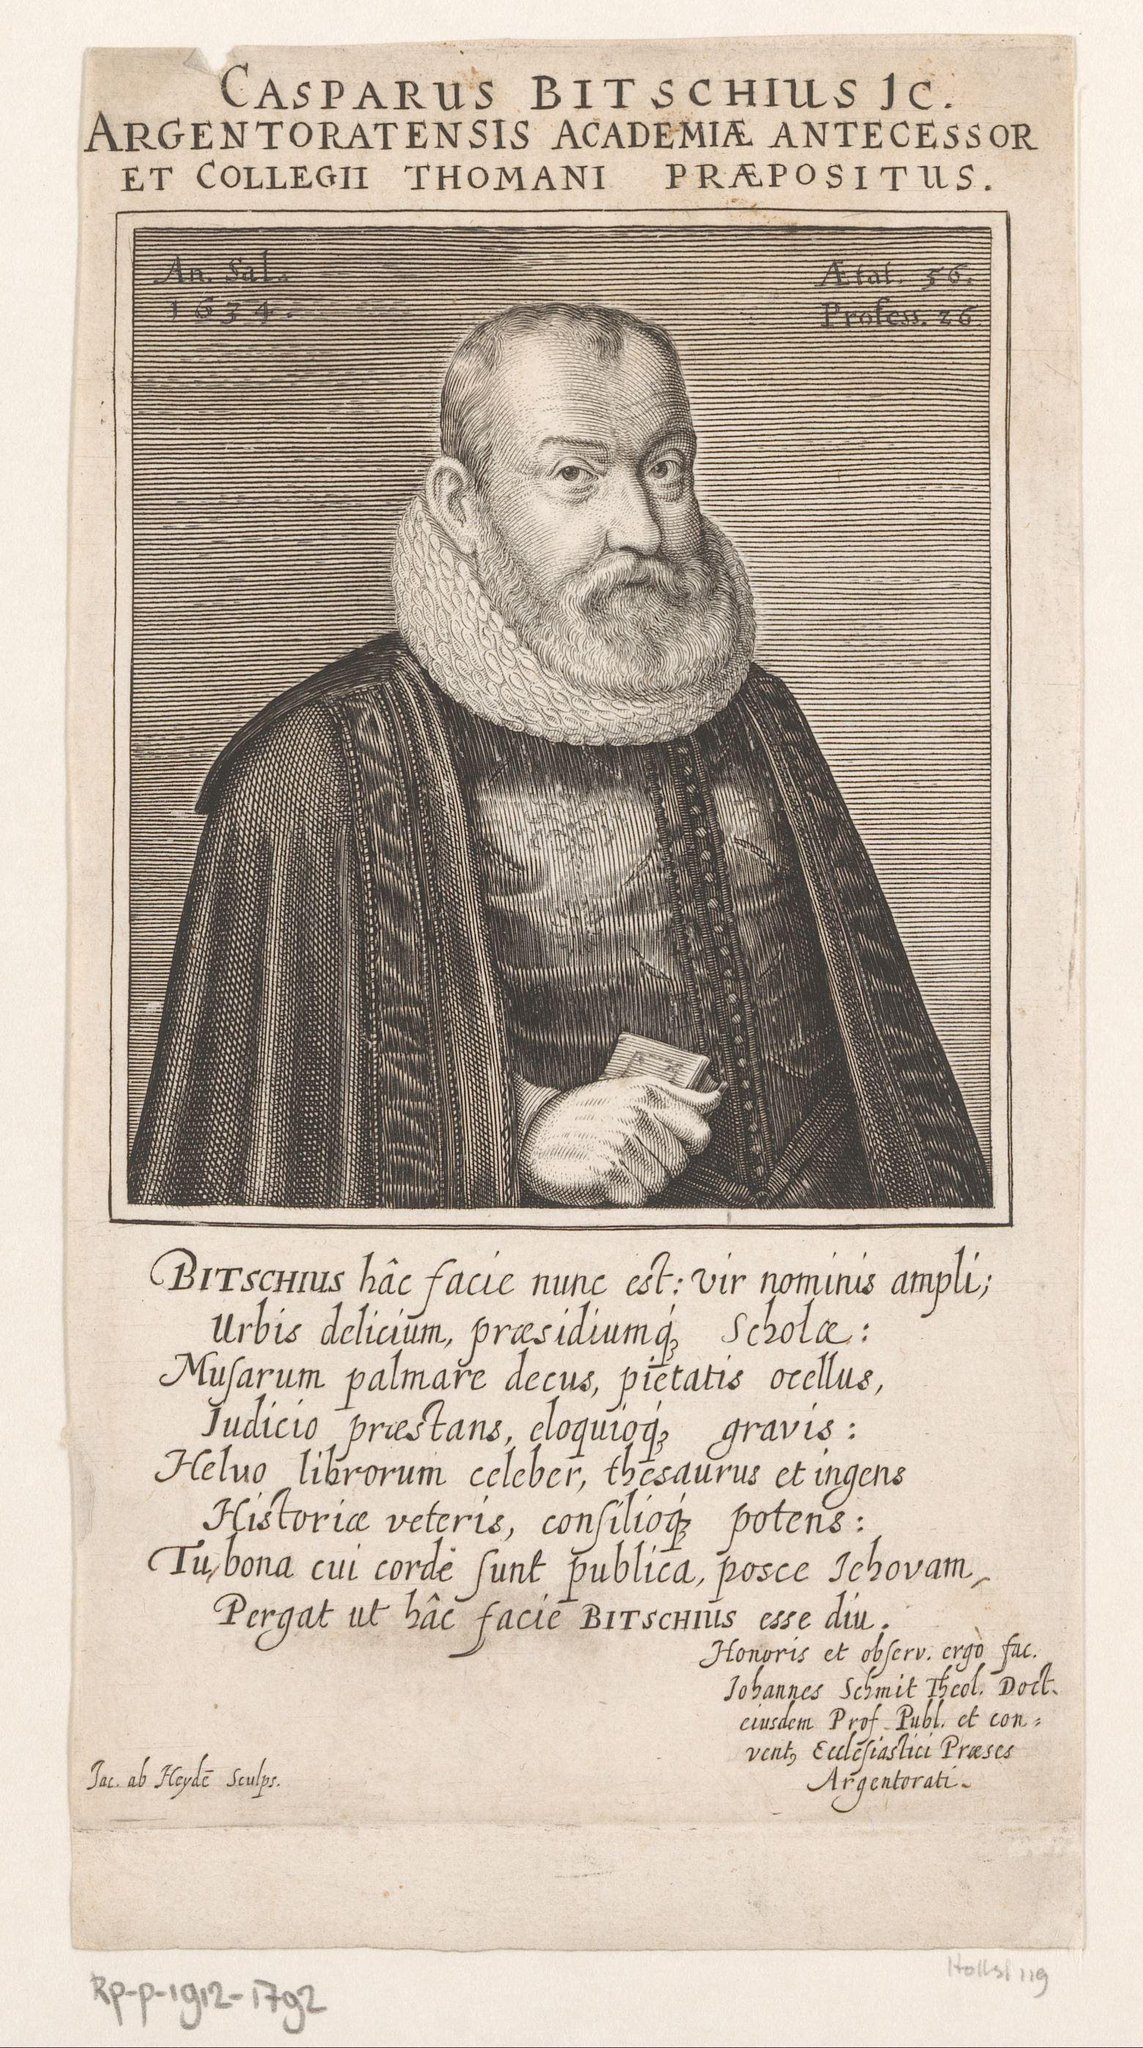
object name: print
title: Portret van Caspar Bitsch op 56-jarige leeftijd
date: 1634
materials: paper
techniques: engraving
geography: straatsburg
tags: historical persons, book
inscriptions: collector's mark: Lugt 2228